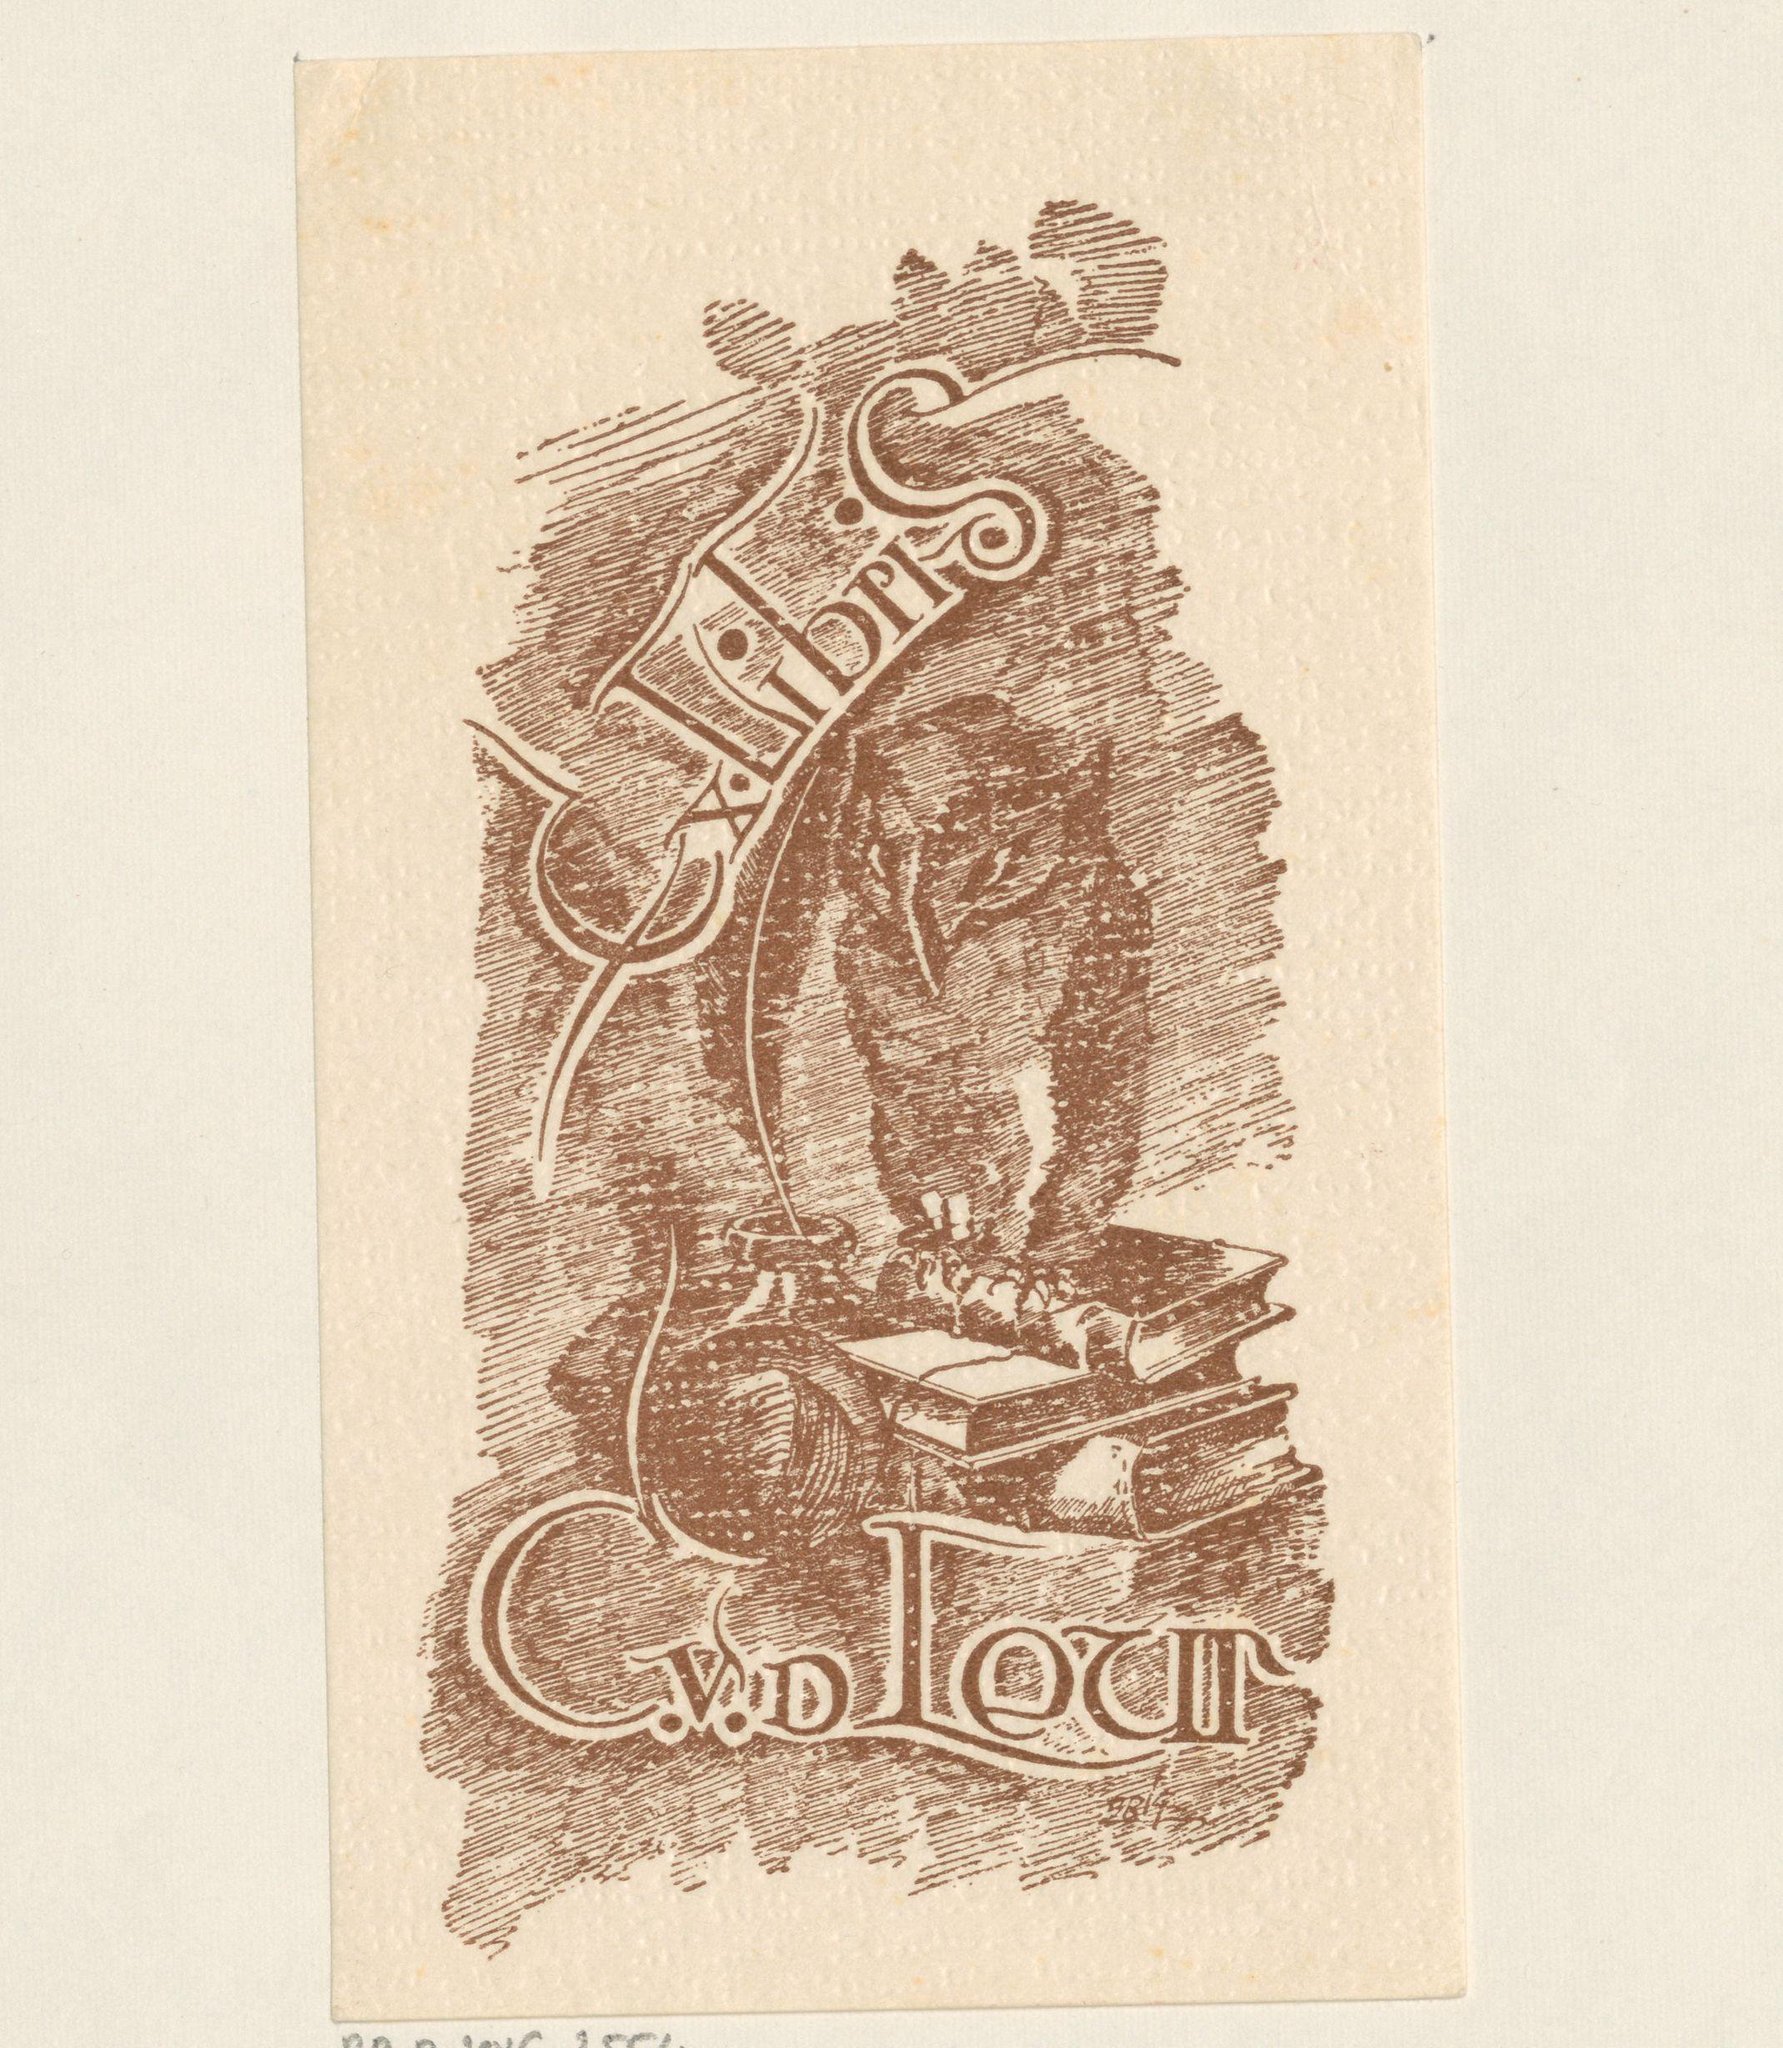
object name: bookplate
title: Ex libris van C. v.d. Leur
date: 1948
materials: paper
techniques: printing block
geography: netherlands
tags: quill, ink-well, owls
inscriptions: signature, date and inscription: ‘J. v.d. Leur / cliché / 1948 / Hollanda’